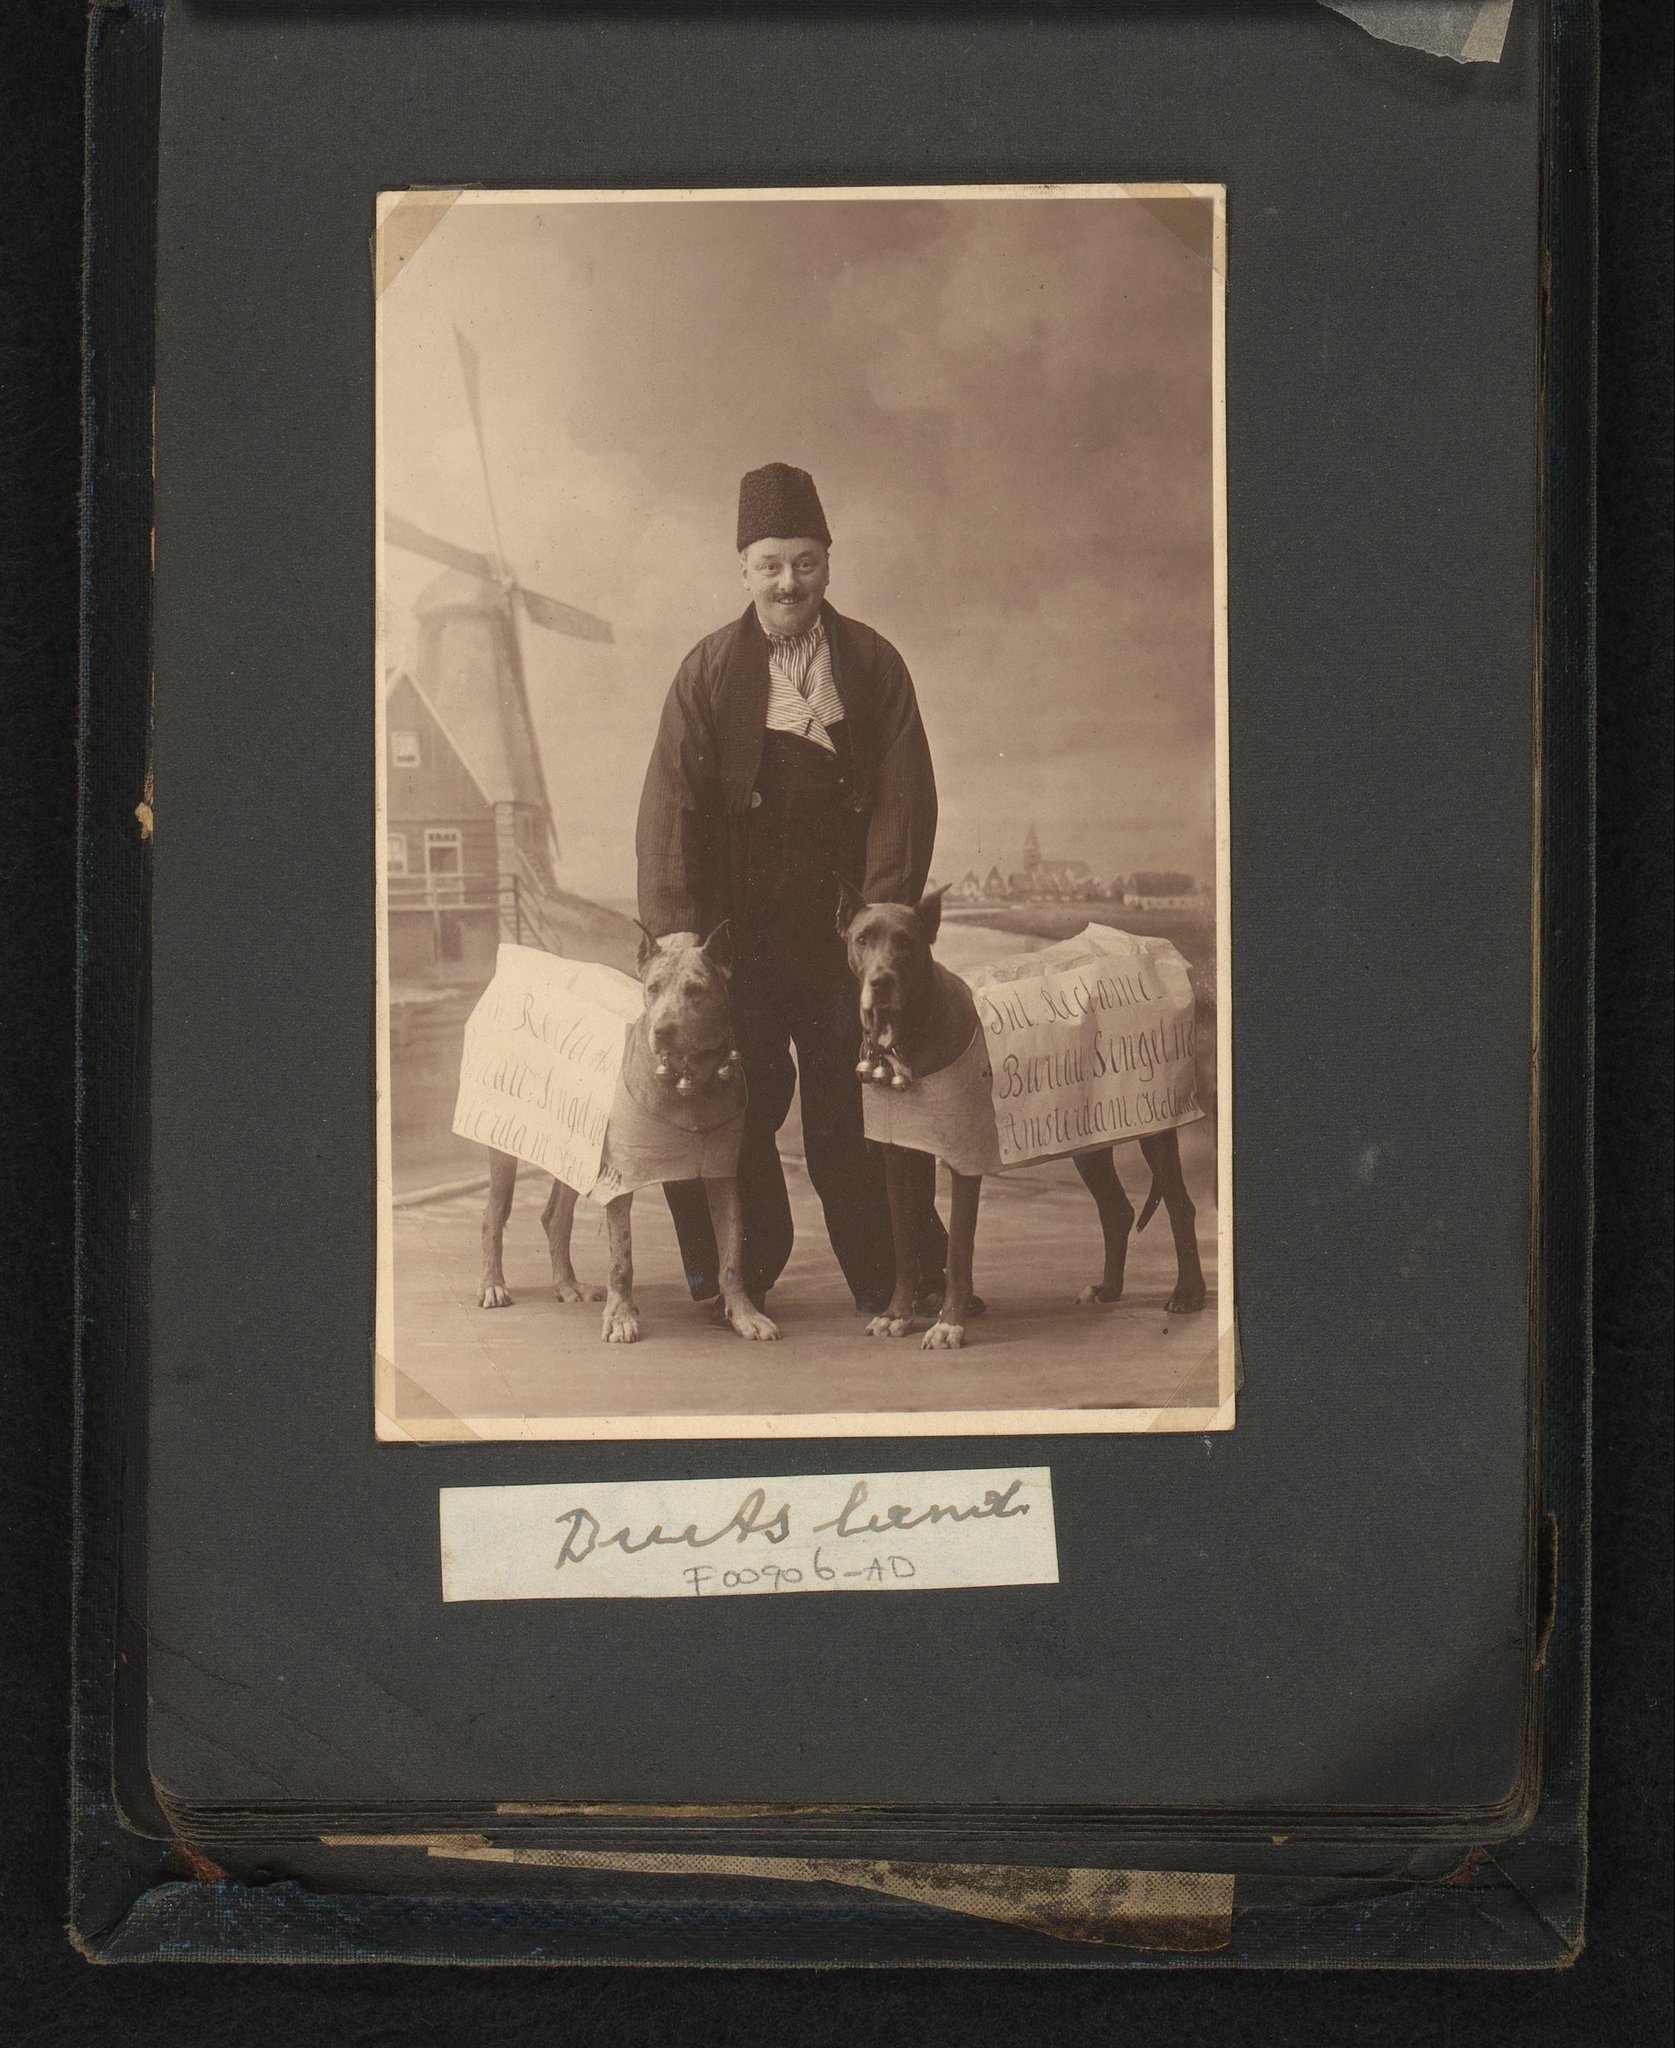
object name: photograph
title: Twee honden met reclameteksten voor reclamebureau te Amsterdam met een man in boerenkostuum voor een decor met molen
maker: Anonymous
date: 1930-1940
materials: photographic support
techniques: gelatin silver print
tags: advertising, adult man, historical persons, folk costume, regional costume, dog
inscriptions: annotation: ‘Drents [...]’